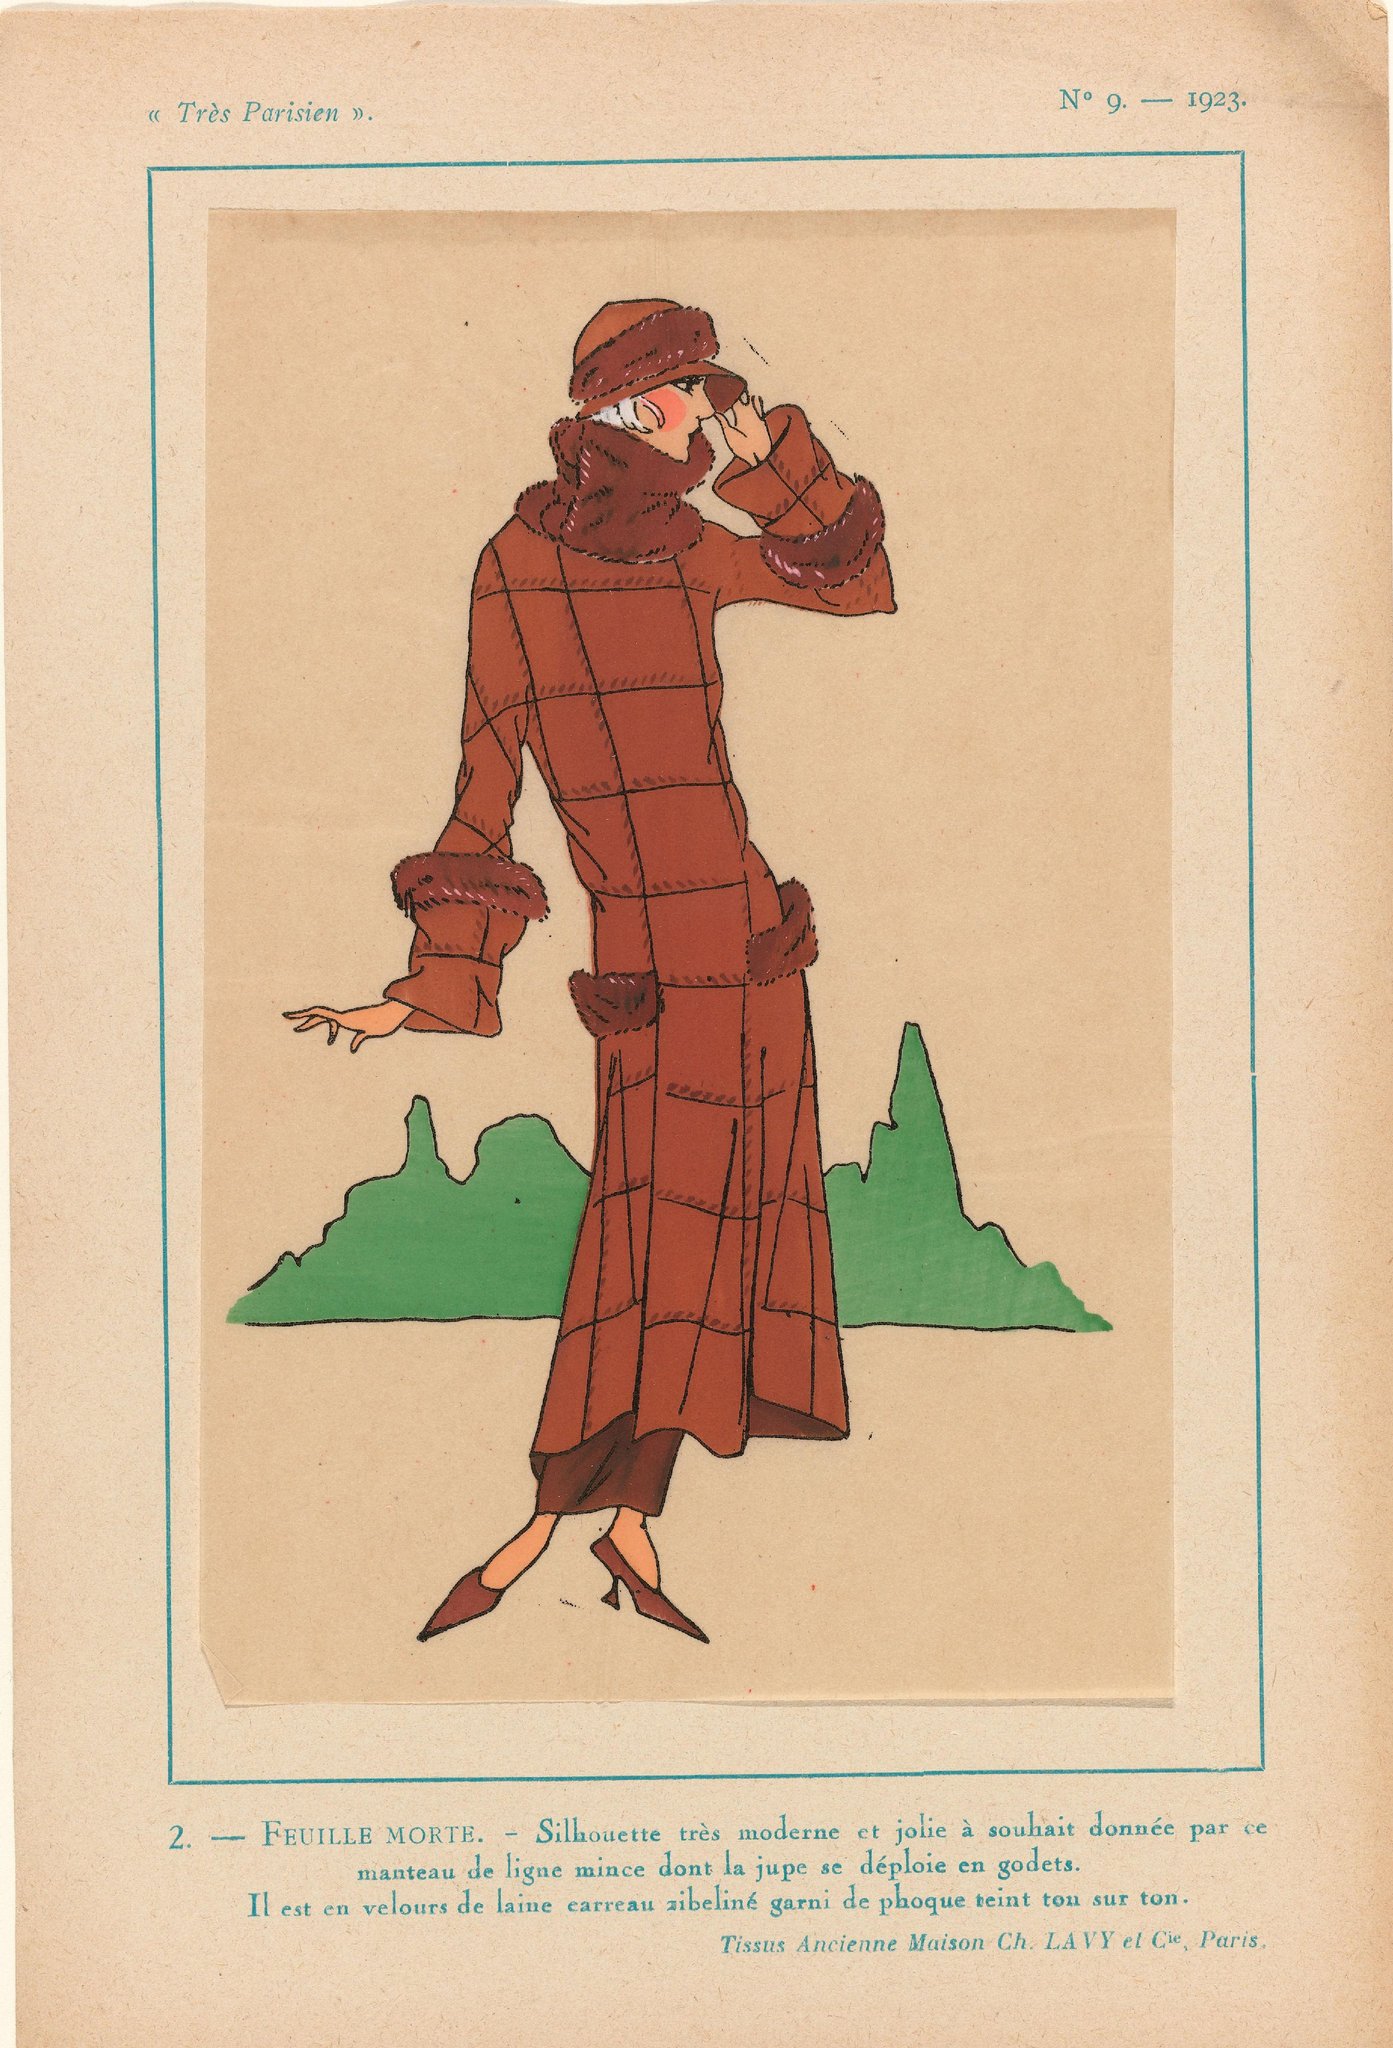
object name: fashion print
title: Très Parisien, 1923, No 9: 2.- FEUILLE MORTE. - Silhouette très moderne...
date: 1923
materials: paper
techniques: hand coloring, letterpress printing, lithography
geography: paris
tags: border, ribbon, braid (+ fur used for clothes), coat (+ women's clothes), fashion plates, skirt (+ women's clothes)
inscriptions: caption: ‘2. - FEUILLE MORTE. - Silhouette très moderne et jolie à souhait donnée par ce manteau de ligne mince dont la jupe se déploie en godets. Il est en velours de laine carreau zibeliné garni de phoque teint ton sur ton. / Tissus Ancienne Maison Ch. LAVY et Cie, Paris.’, title: ‘Très Parisien / No 9. - 1923’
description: Mantel, slank model met bij de rok 'godets' (valse plooien), van geruite 'velours de laine' (wolfluweel) gegarneerd met marterbont in dezelfde kleur. Stoffen van Ancienne Maison Ch. Lavy et Cie. Accessories: cloche (pothoed), pumps. Prent uit het modetijdschrift Très Parisien (1920-1936).